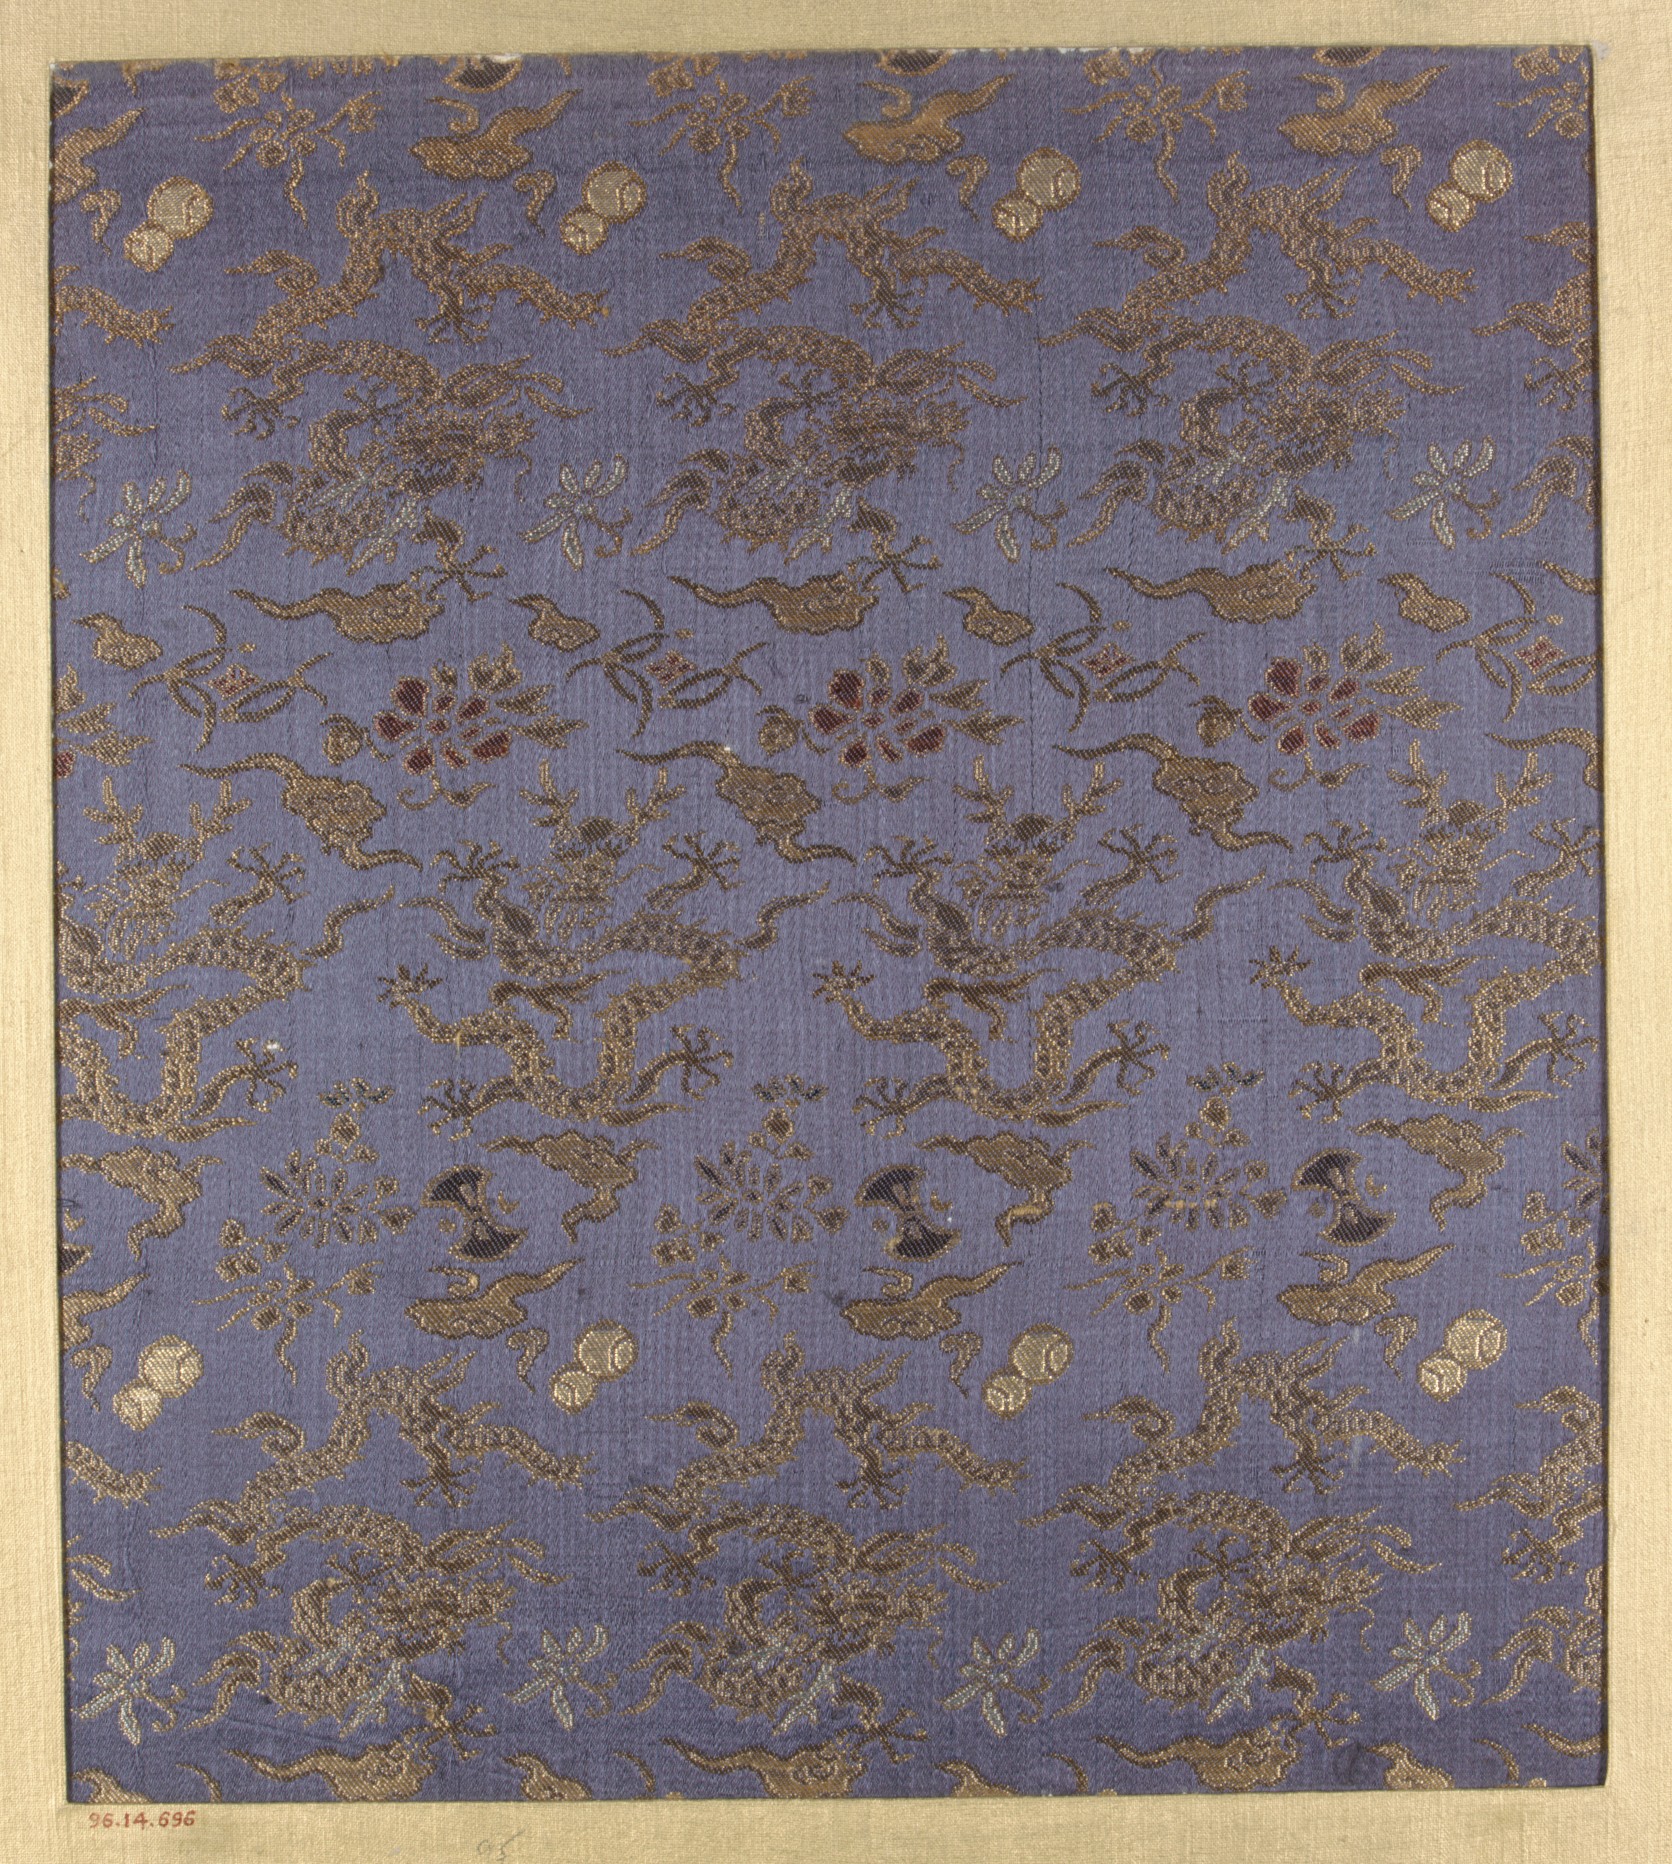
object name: piece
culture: japanese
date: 1701-1900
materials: silk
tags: dragons,flowers